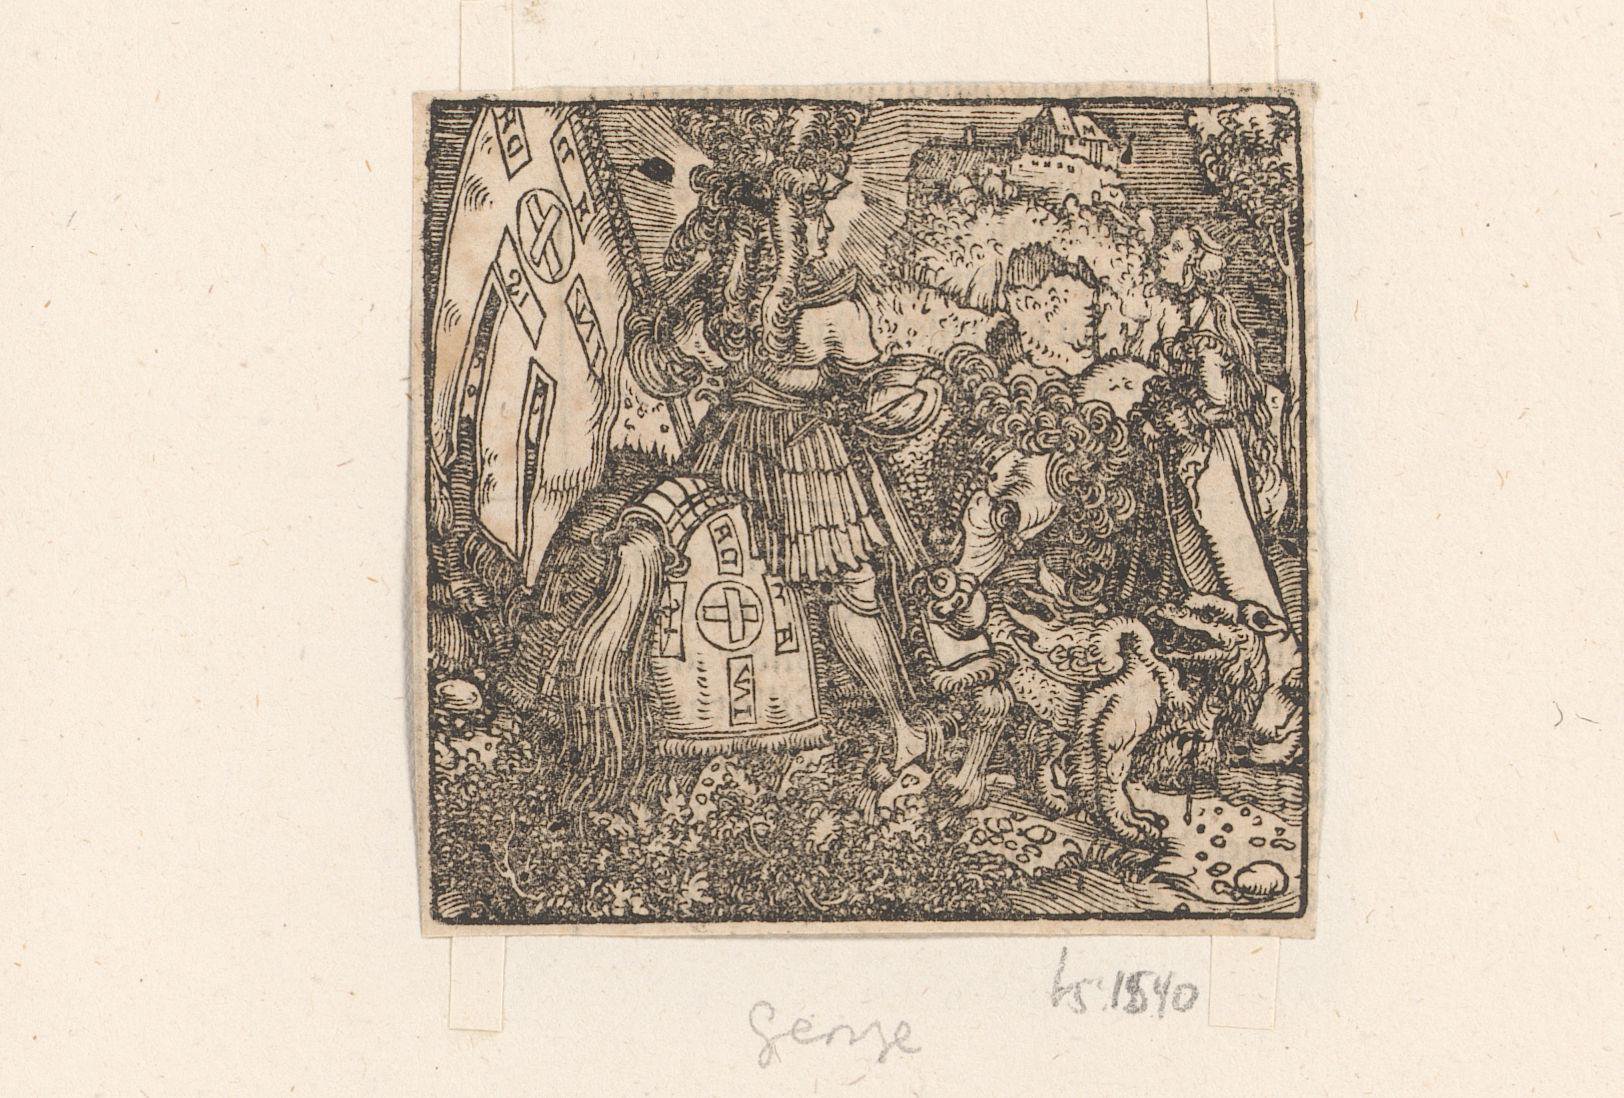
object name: album leaf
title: Heilige Joris trekt ten strijde tegen de draak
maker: Anonymous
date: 1500-1536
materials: paper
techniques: woodcut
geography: germany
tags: st. george and the dragon: dressed in armour and mounted on a (white) horse he brandishes his sword (his lance lies already broken on the ground); the princess nearby may be shown praying or fleeing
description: De Heilige Joris rijdt te paard op de draak af. Naast de draak staat de prinses. Prent maakt deel uit van een album.